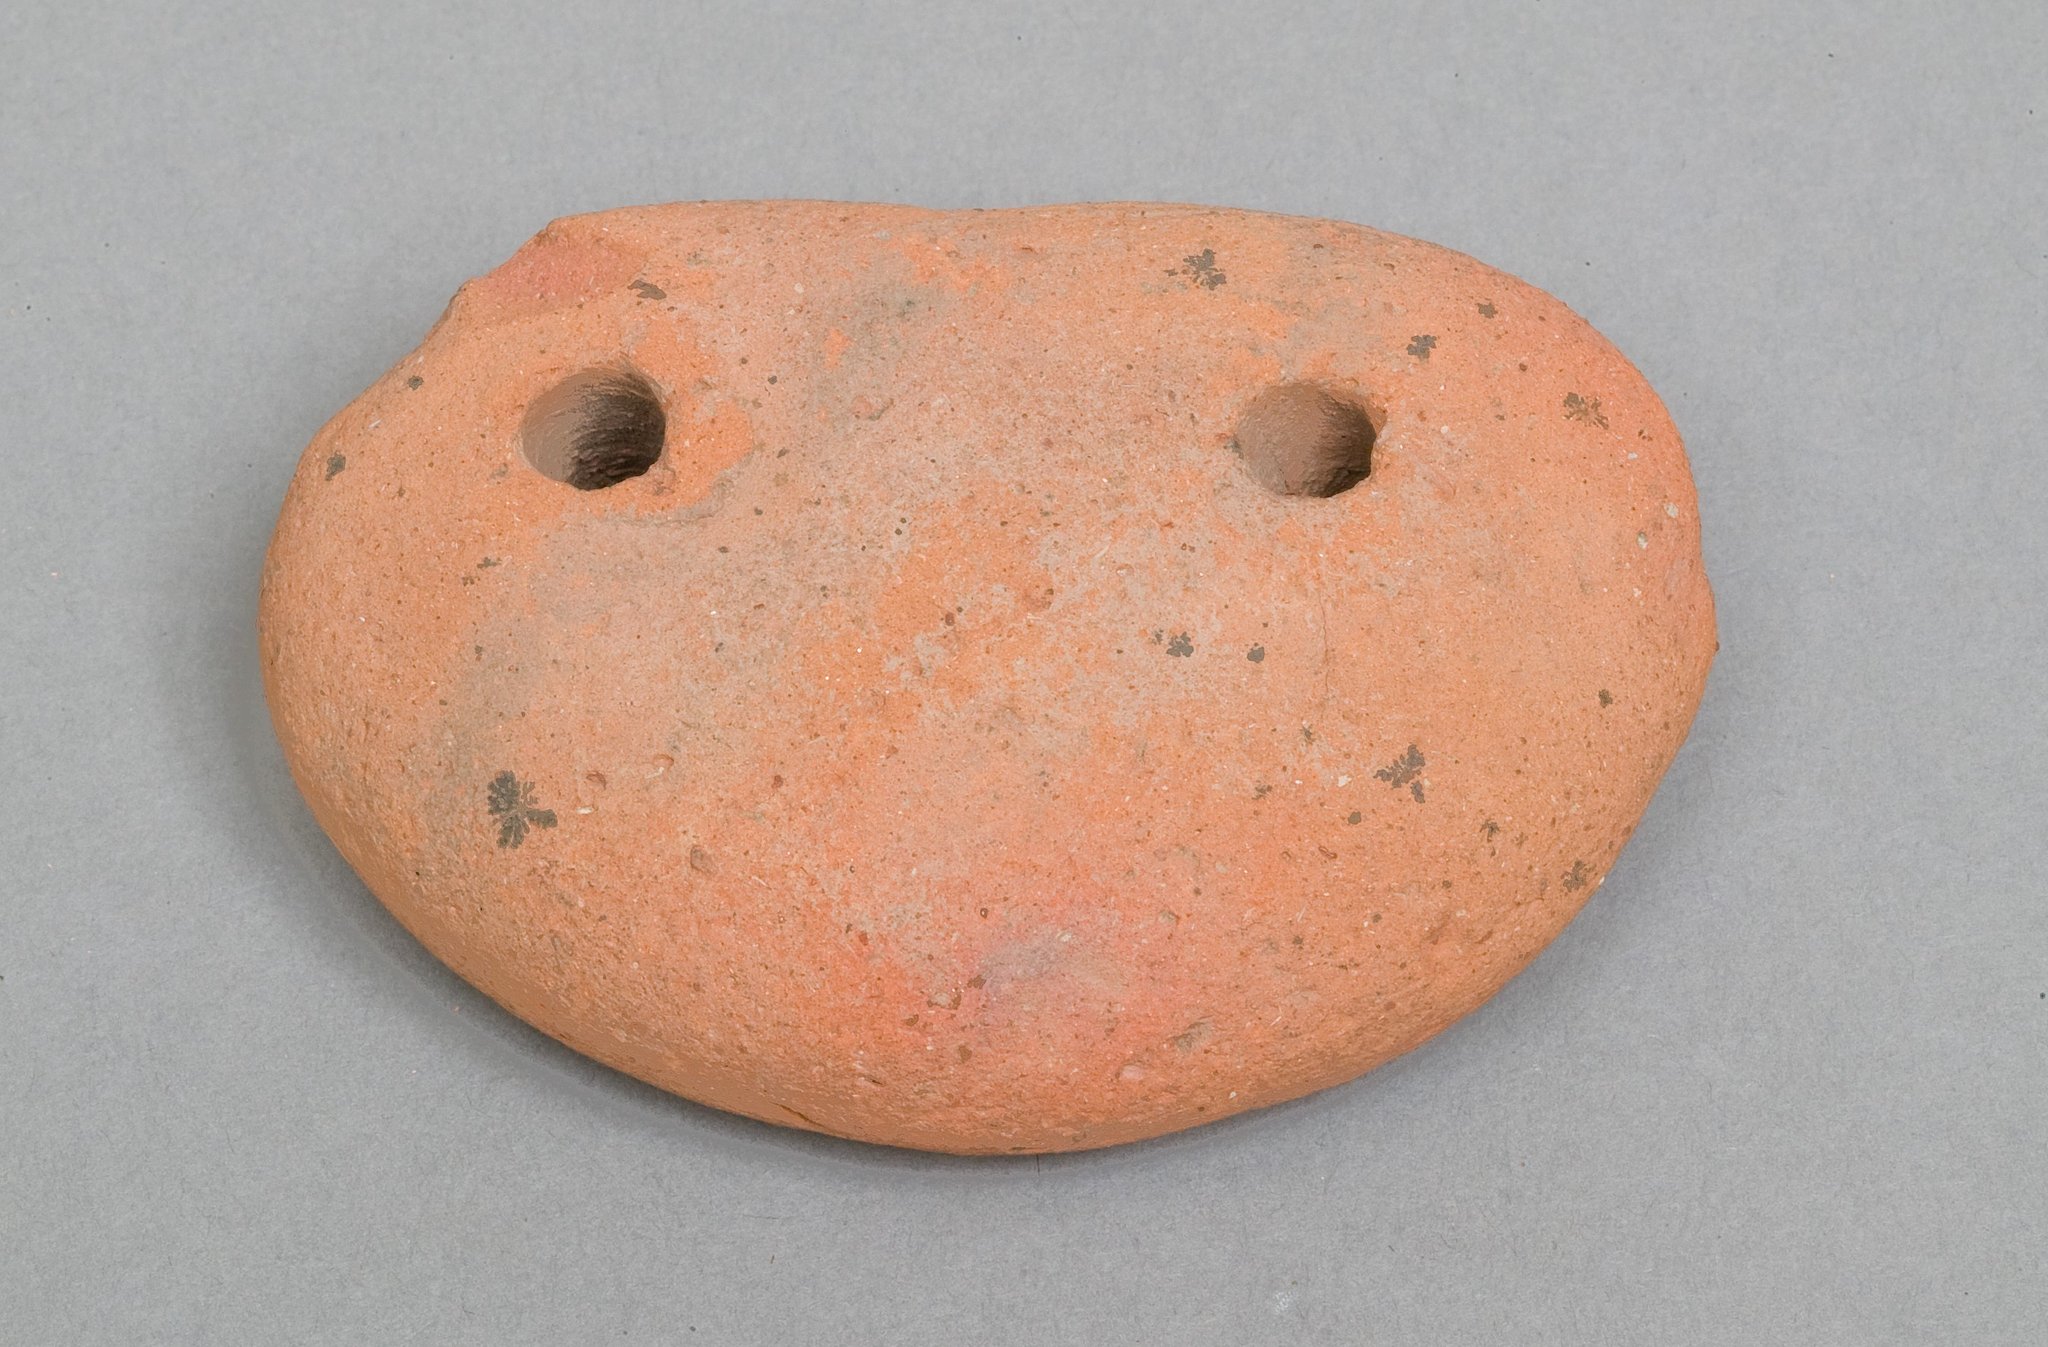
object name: weighing down device fish net sinker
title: Weighing down device (fish net sinker?)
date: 1295-1070 BCE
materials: pottery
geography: egypt